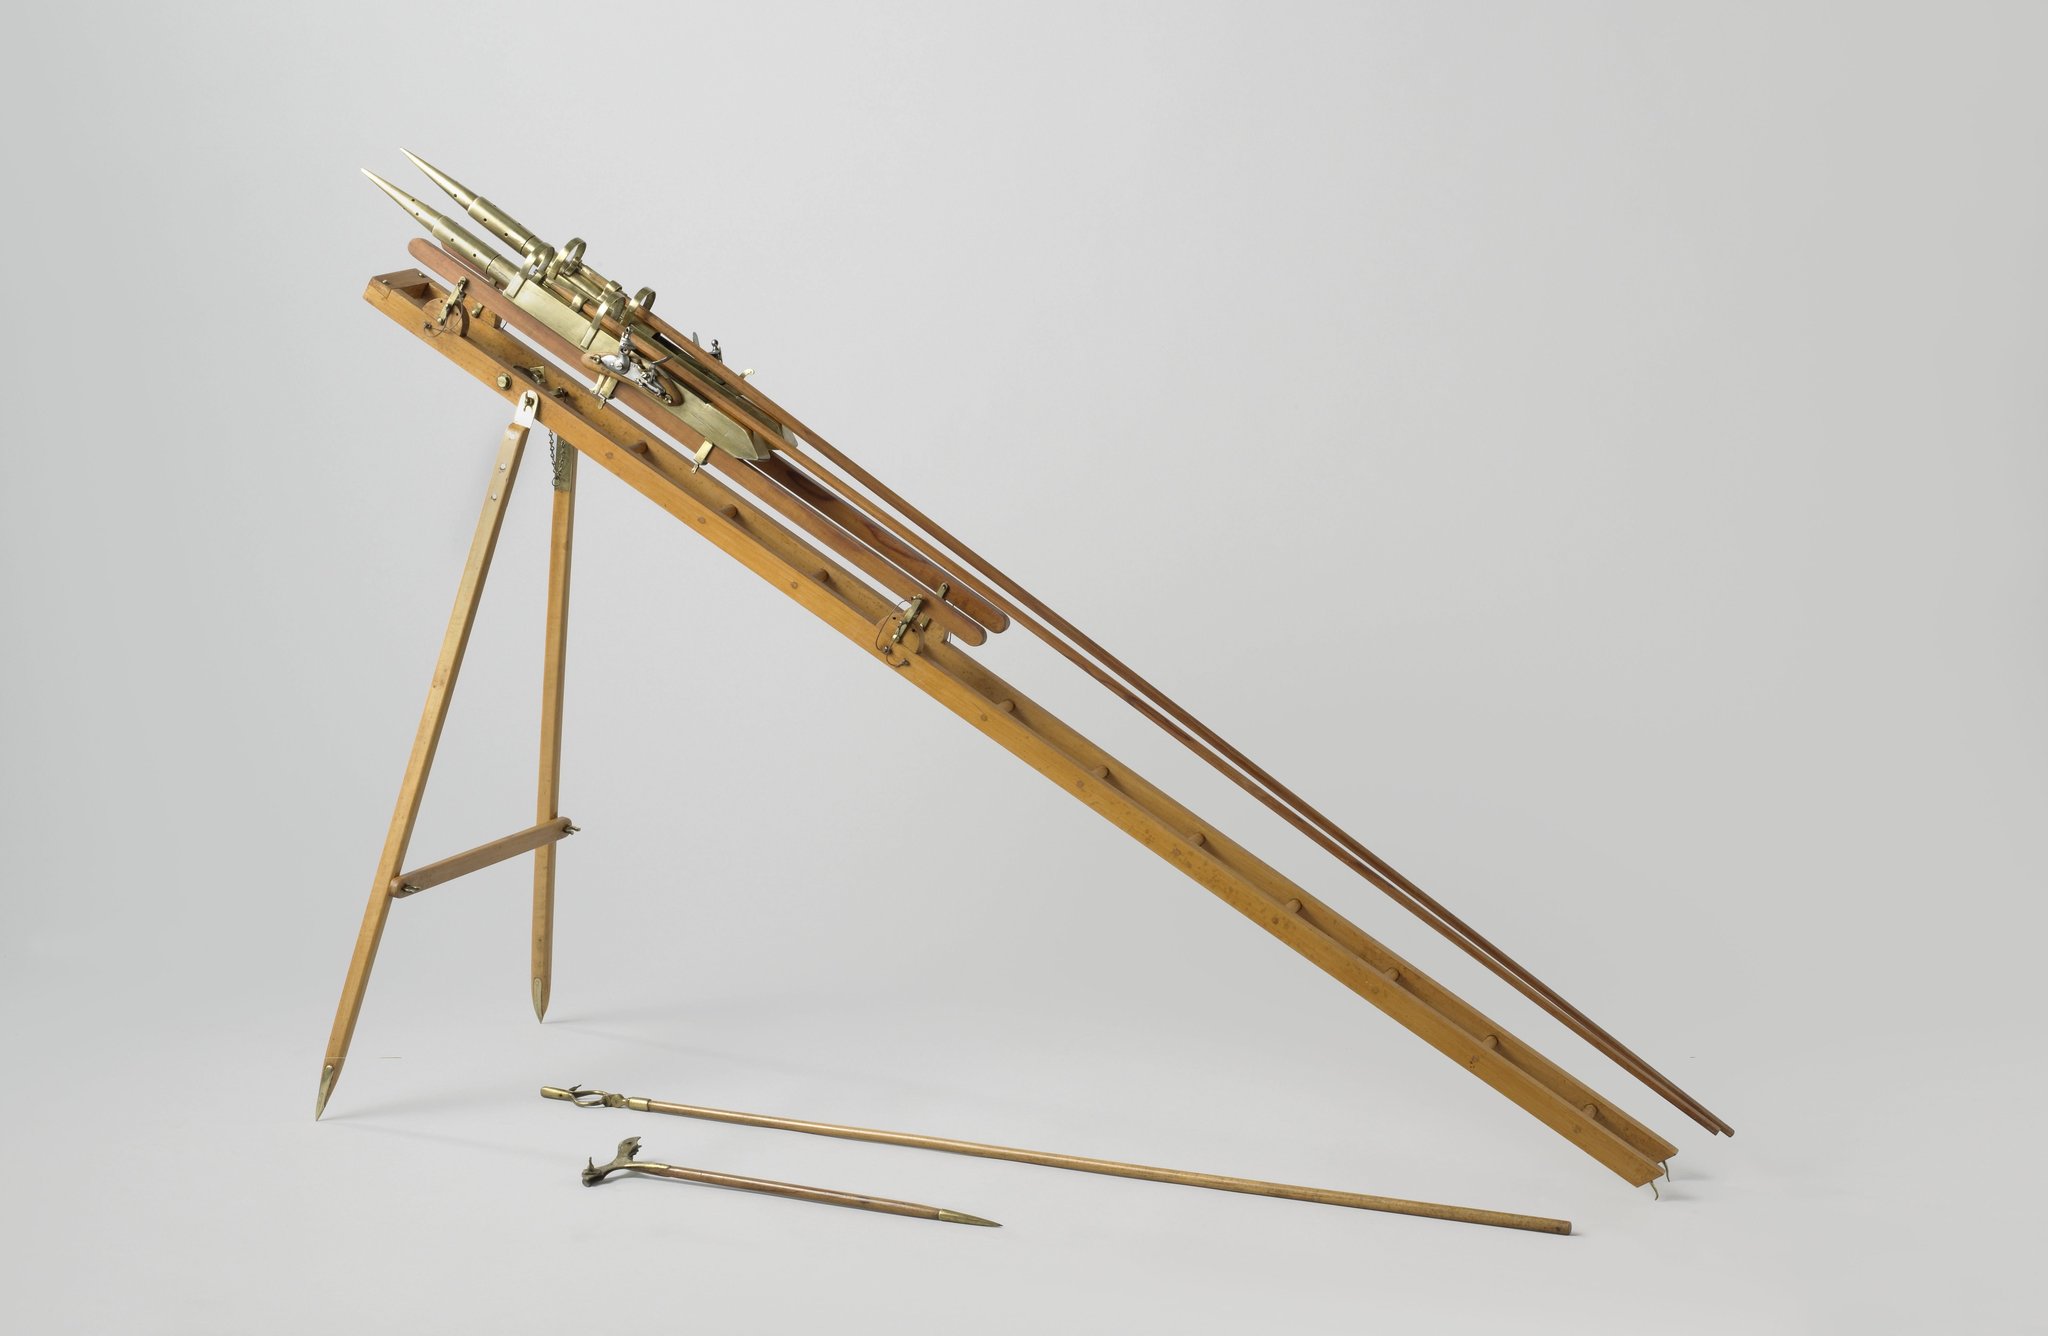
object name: demonstration model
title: Model of Two Congreve Rockets with Launching Gear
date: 1818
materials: brass, stone, iron, leather, fiber, wood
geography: rotterdam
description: Het meest opvallende aan dit model zijn de extra balken die de kamers ondersteunen: die komen op de originele ontwerpen van William Congreve niet voor. Brandraketten naar Congreve's ontwerp werden door de Engelsen gebruikt bij het bombardement van Vlissingen in 1809 en van Algiers in 1816. Het model is bijna identiek aan NG-MC-1026.